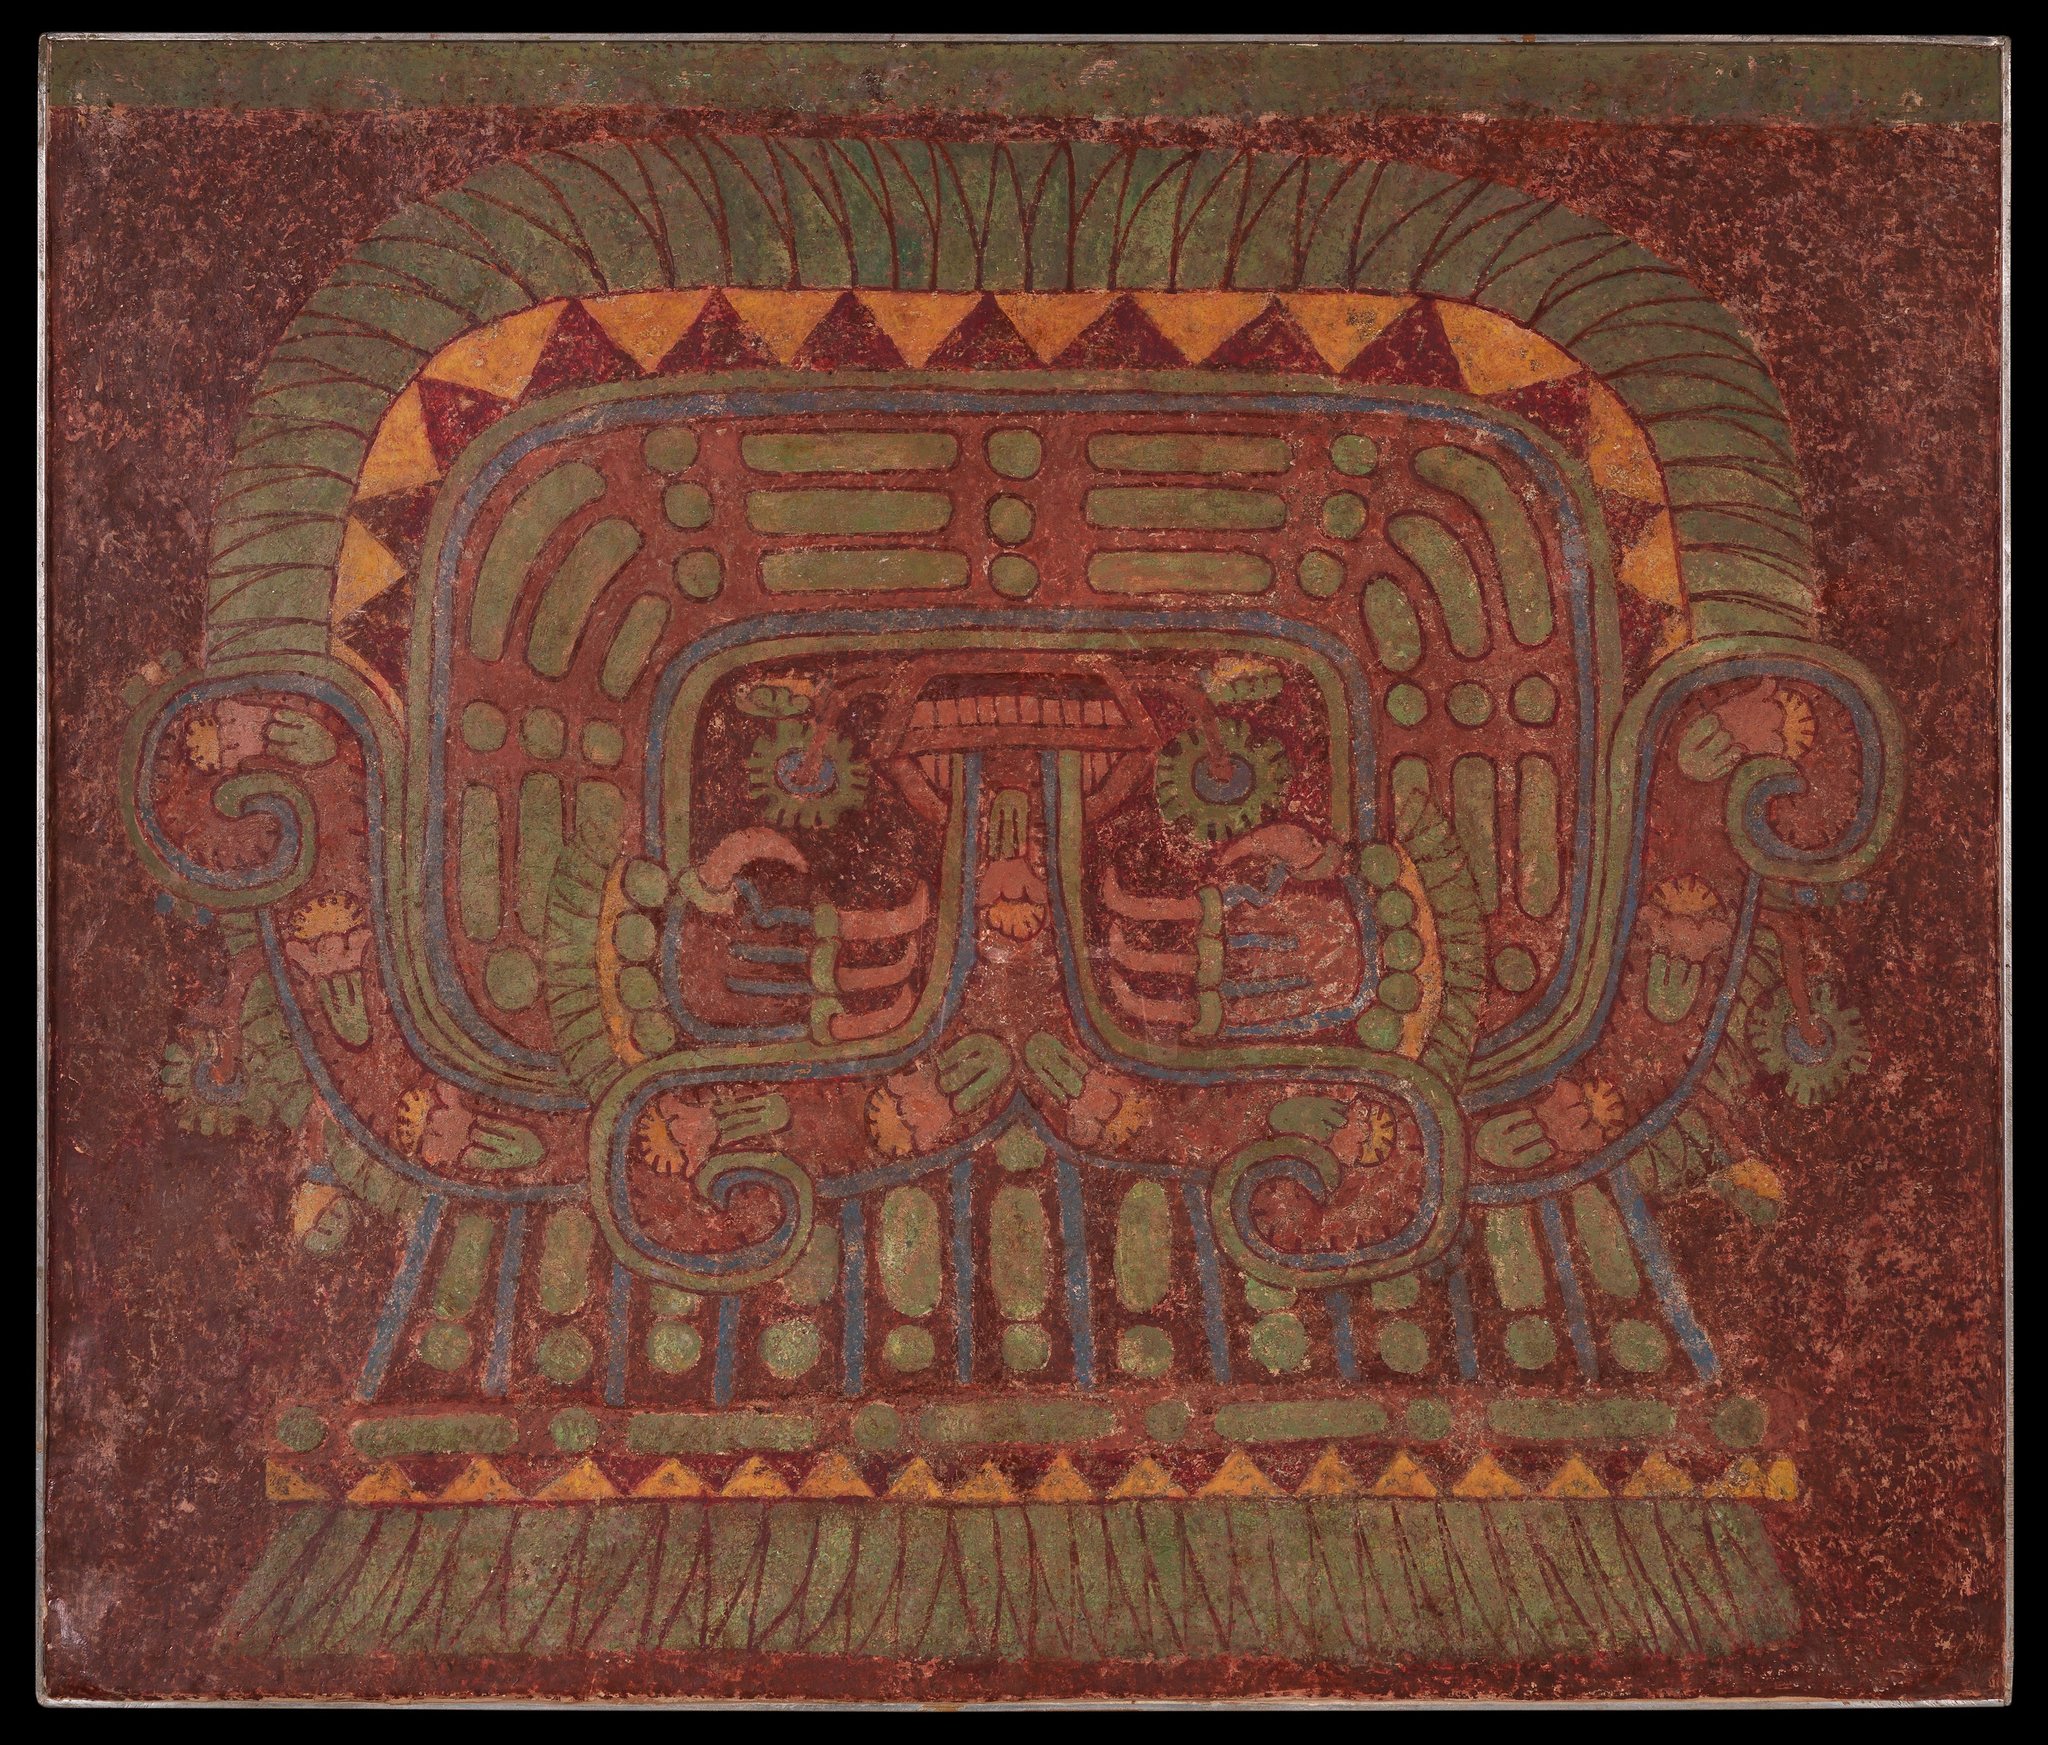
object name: fresco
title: Mural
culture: teotihuacan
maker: teotihuacan artist(s)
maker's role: artist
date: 500-550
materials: pigment, plaster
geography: mexico